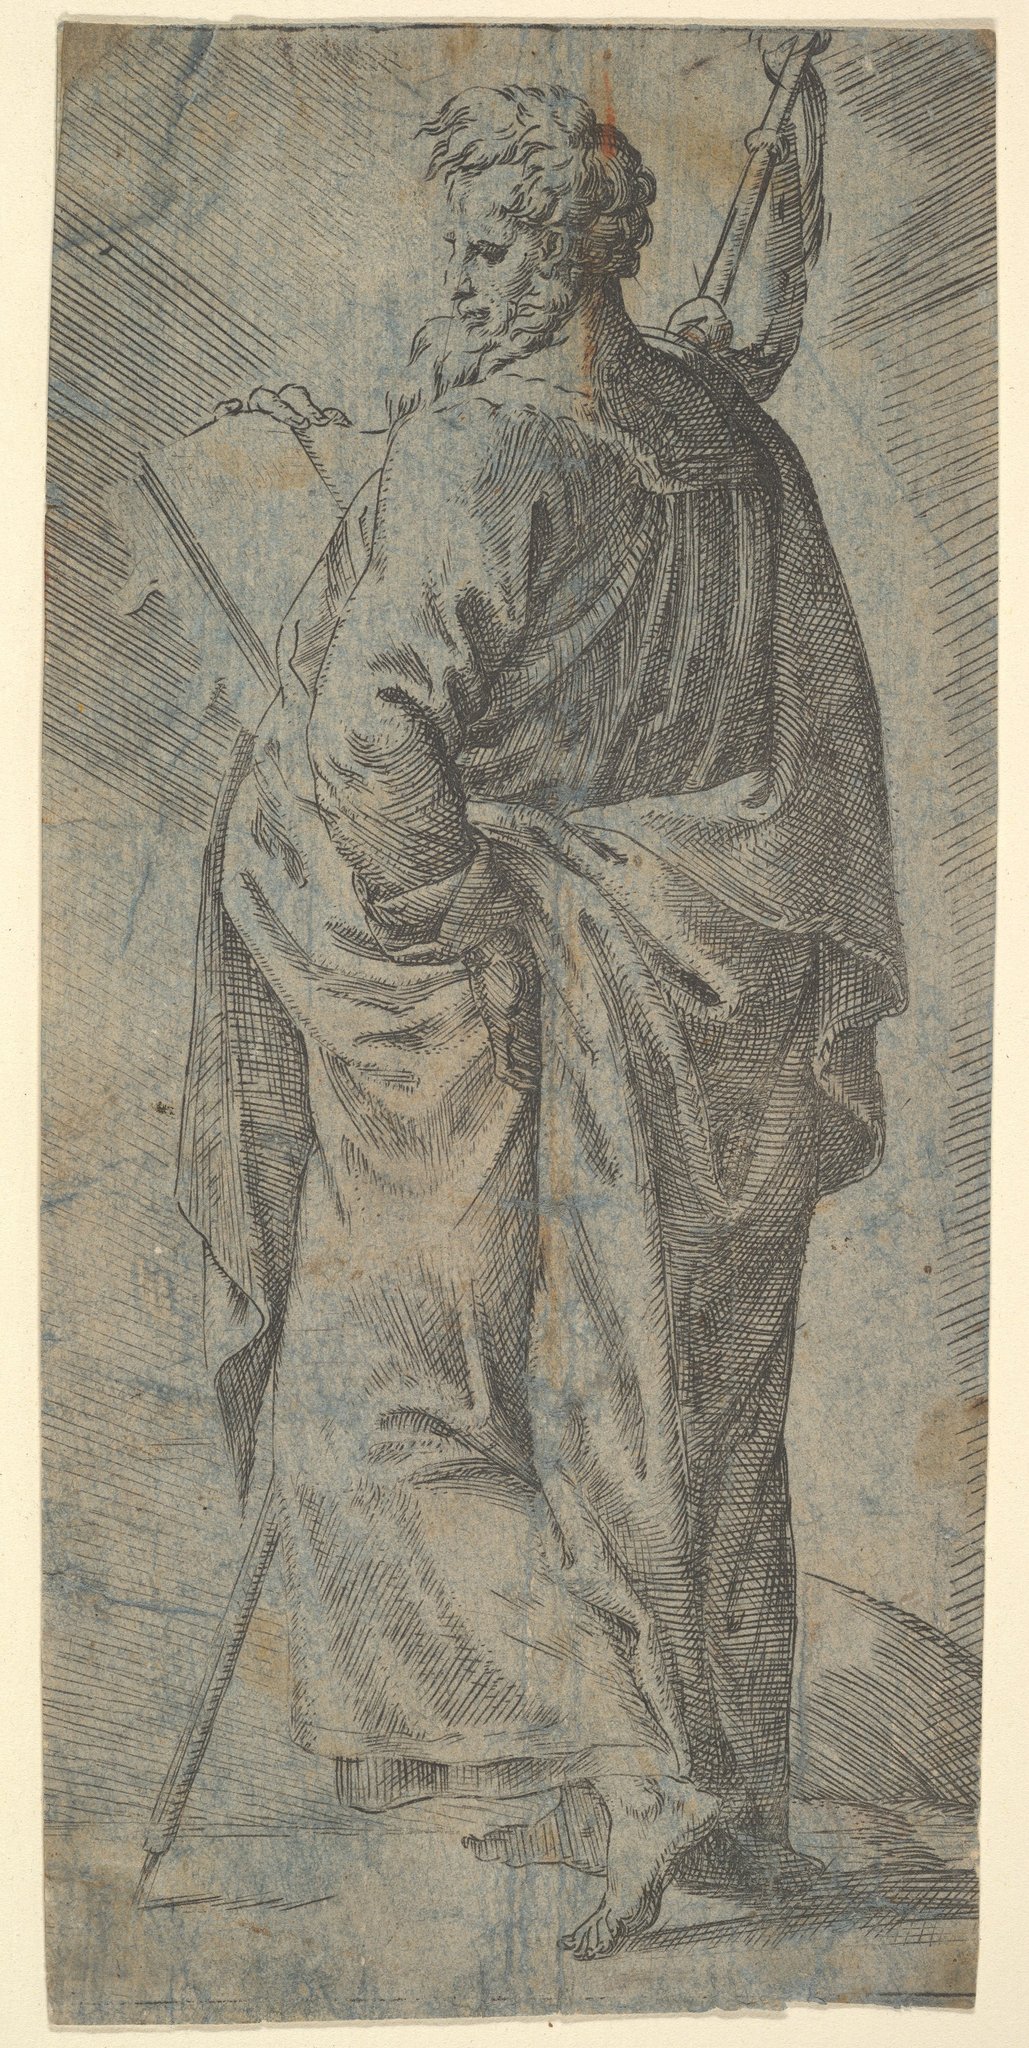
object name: print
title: Male Saint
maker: anonymous, italian, 16th century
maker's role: artist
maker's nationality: italian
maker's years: 1500-1600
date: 1501-1600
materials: paper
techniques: etching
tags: saints